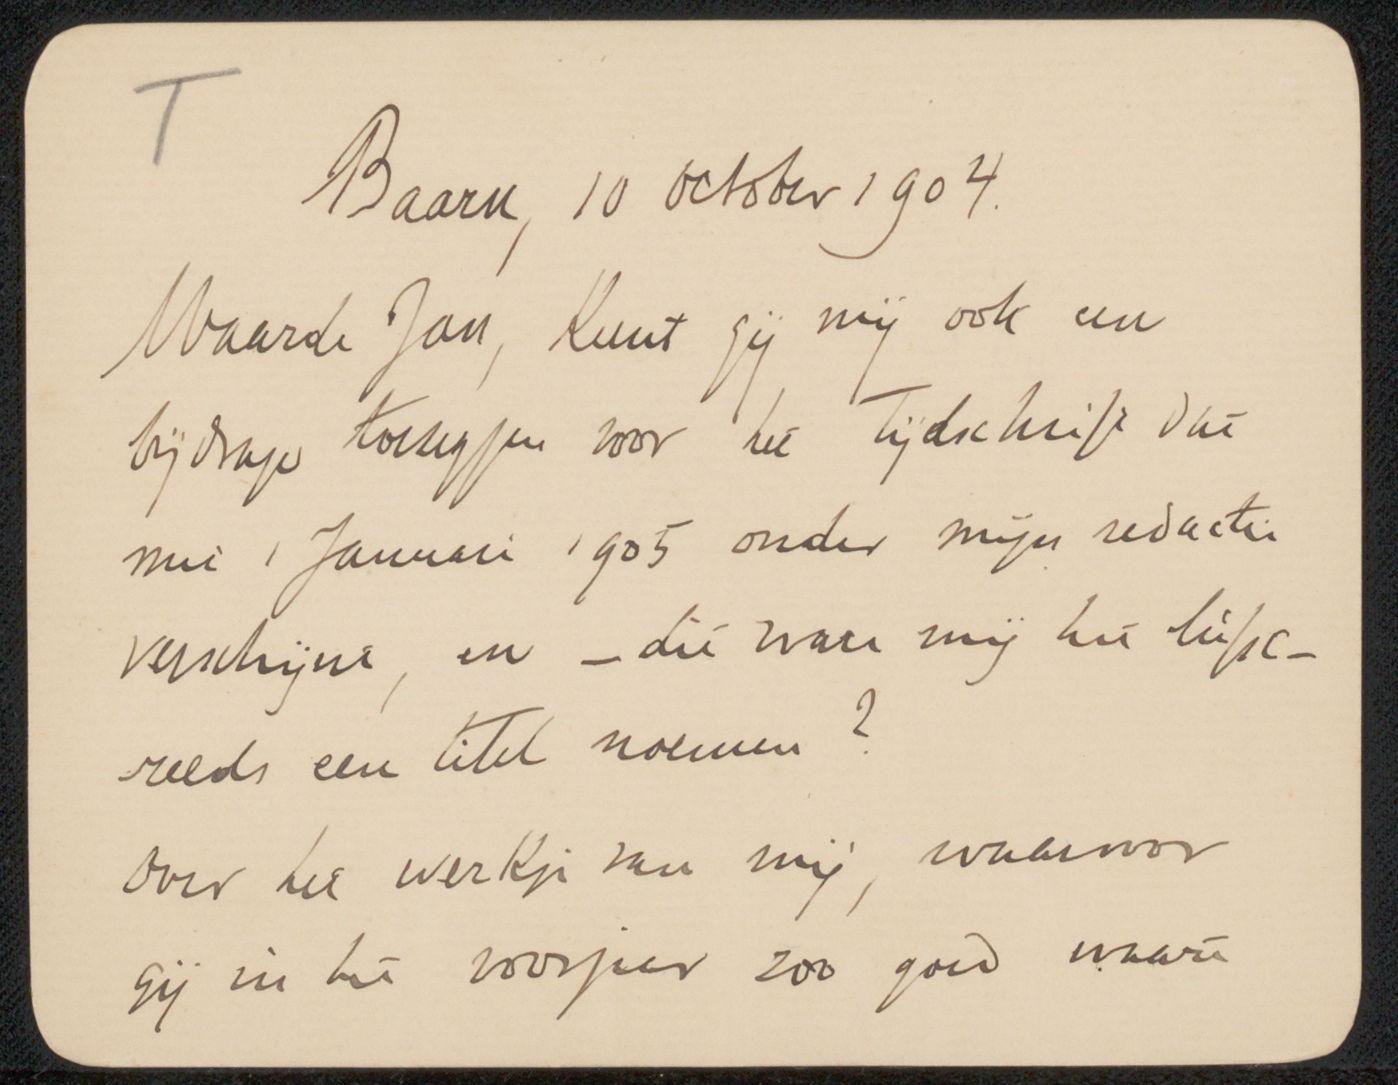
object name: letter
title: Brief aan Jan Veth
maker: karel johan lodewijk alberdingk thijm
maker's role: criticus, prozaschrijver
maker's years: 1864-1952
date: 1904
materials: cardboard, ink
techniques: pen, writing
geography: baarn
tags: dordrecht, amsterdam, painter, draughtsman, designer, jan veth, printed matter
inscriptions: collector's mark: ‘RPK’